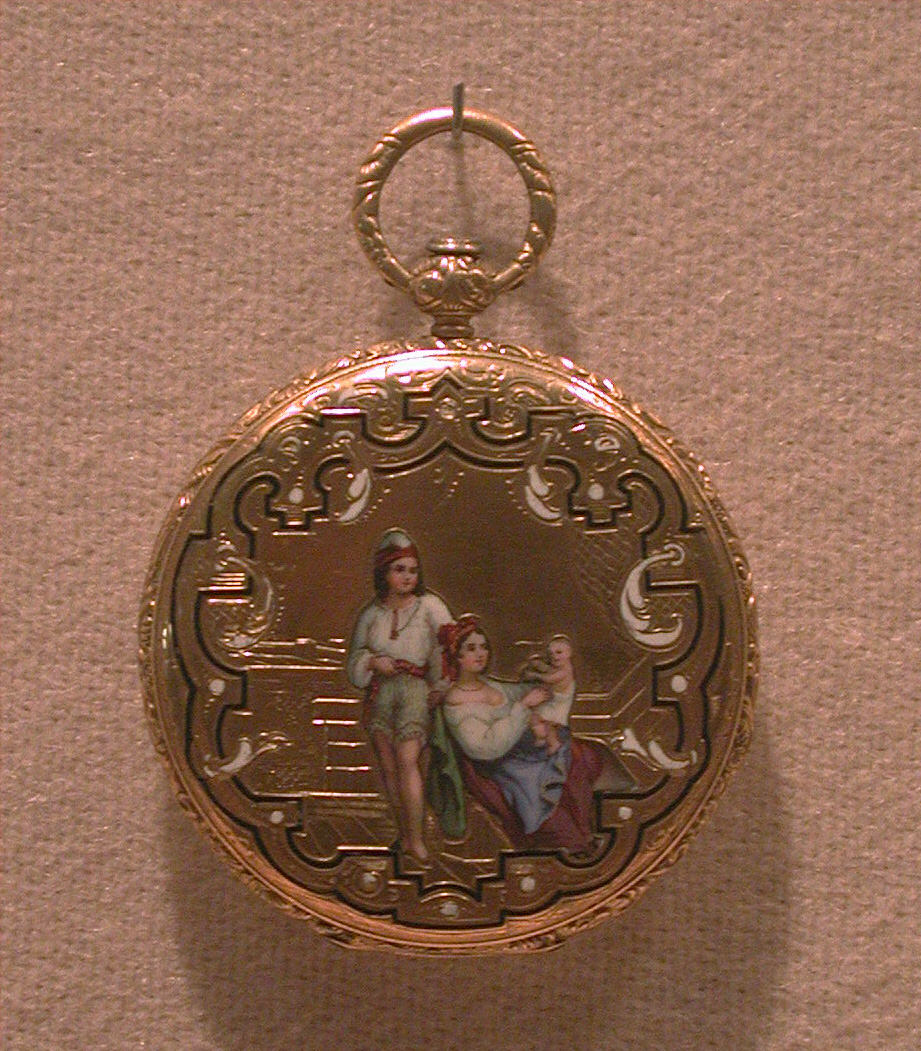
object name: watch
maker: du bois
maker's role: maker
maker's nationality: swiss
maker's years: 1775-1875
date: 1830-1840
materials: enamel, gold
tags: infants,men,women